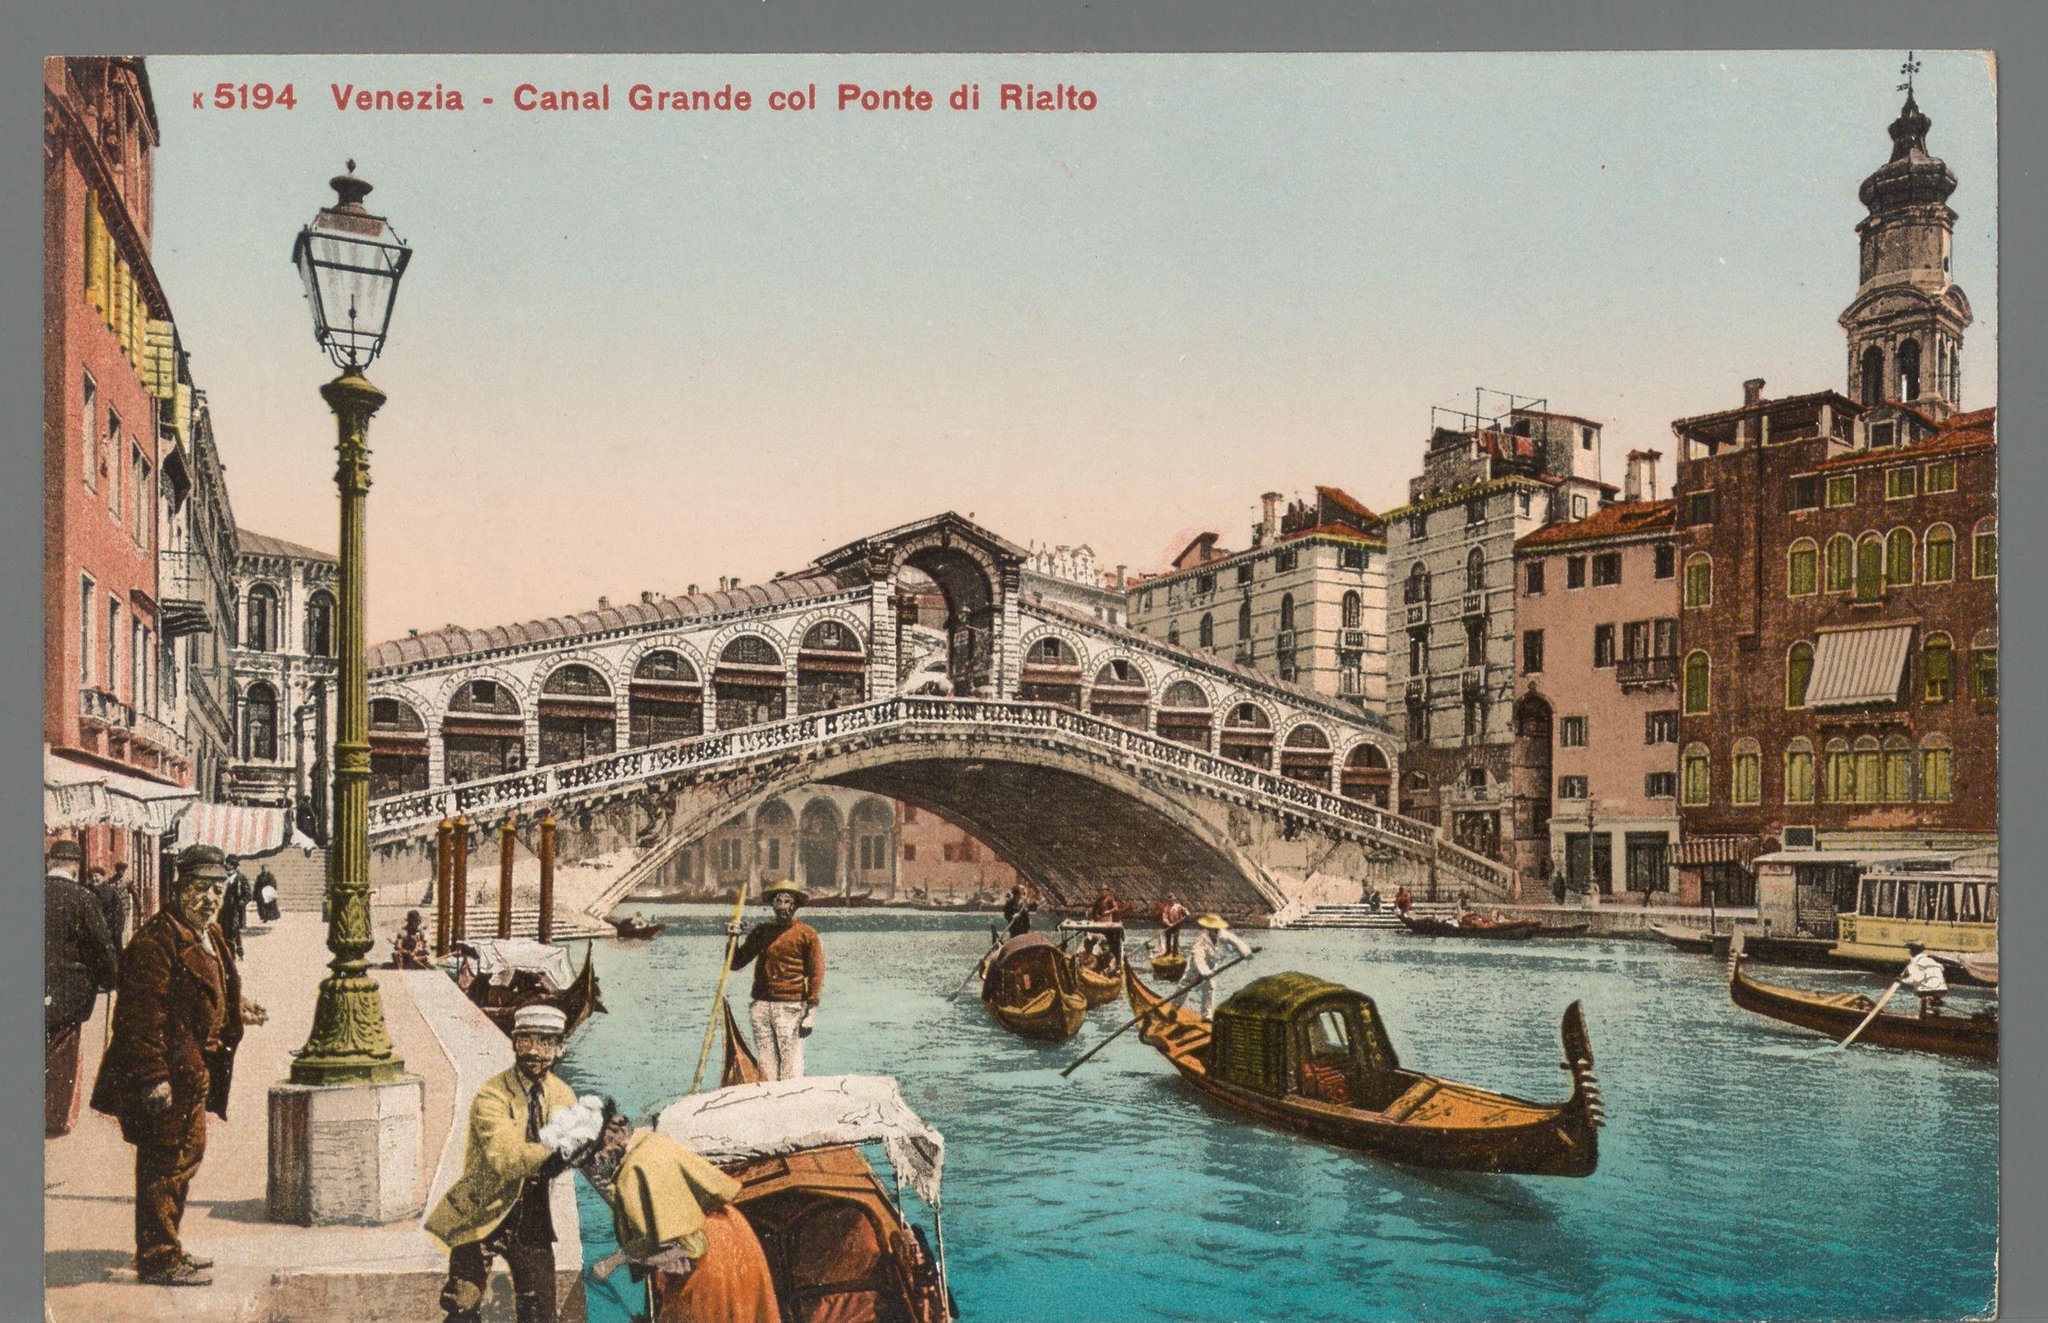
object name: photomechanical print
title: Venezia. Canal Grande col Ponte di Rialto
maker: Anonymous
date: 1905-1930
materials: cardboard, photographic process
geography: venice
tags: bridge in city across river, canal, etc. (+ city(-scape) with figures, staffage), canal, gondola